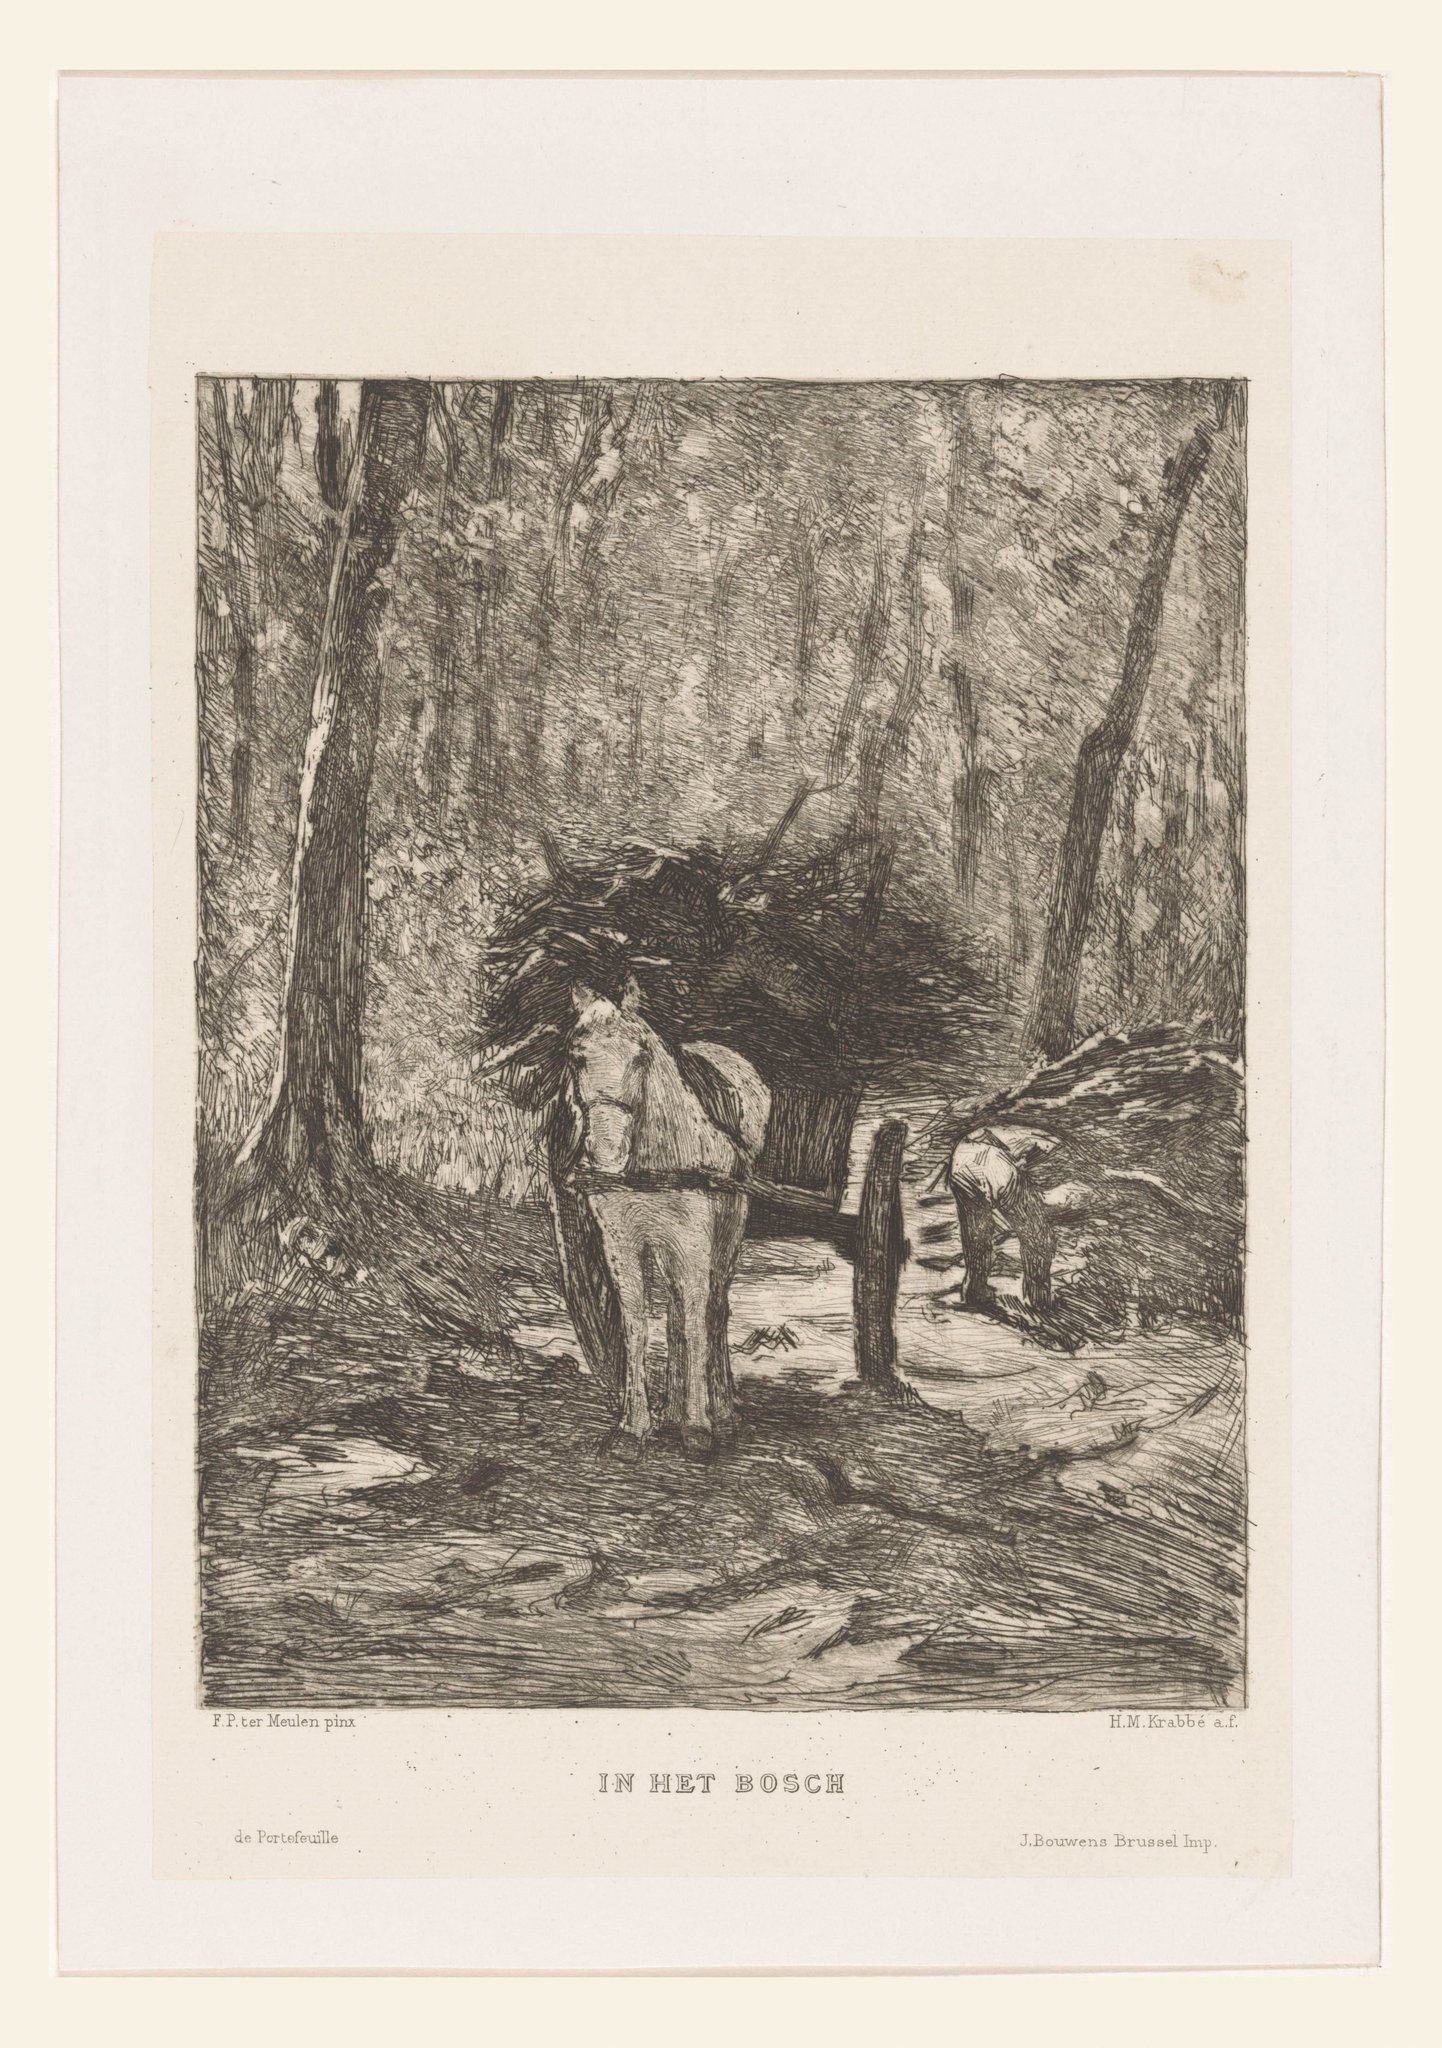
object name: print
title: In het bosch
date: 1878-1889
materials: paper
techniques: etching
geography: brussels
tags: forest, wood, horse, two-wheeled vehicle drawn by one animal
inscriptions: collector's mark: Lugt 2228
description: Op een bospad staat een paard met wagen geladen met sprokkelhout. Rechts raapt een voorovergebogen man takken van de grond.